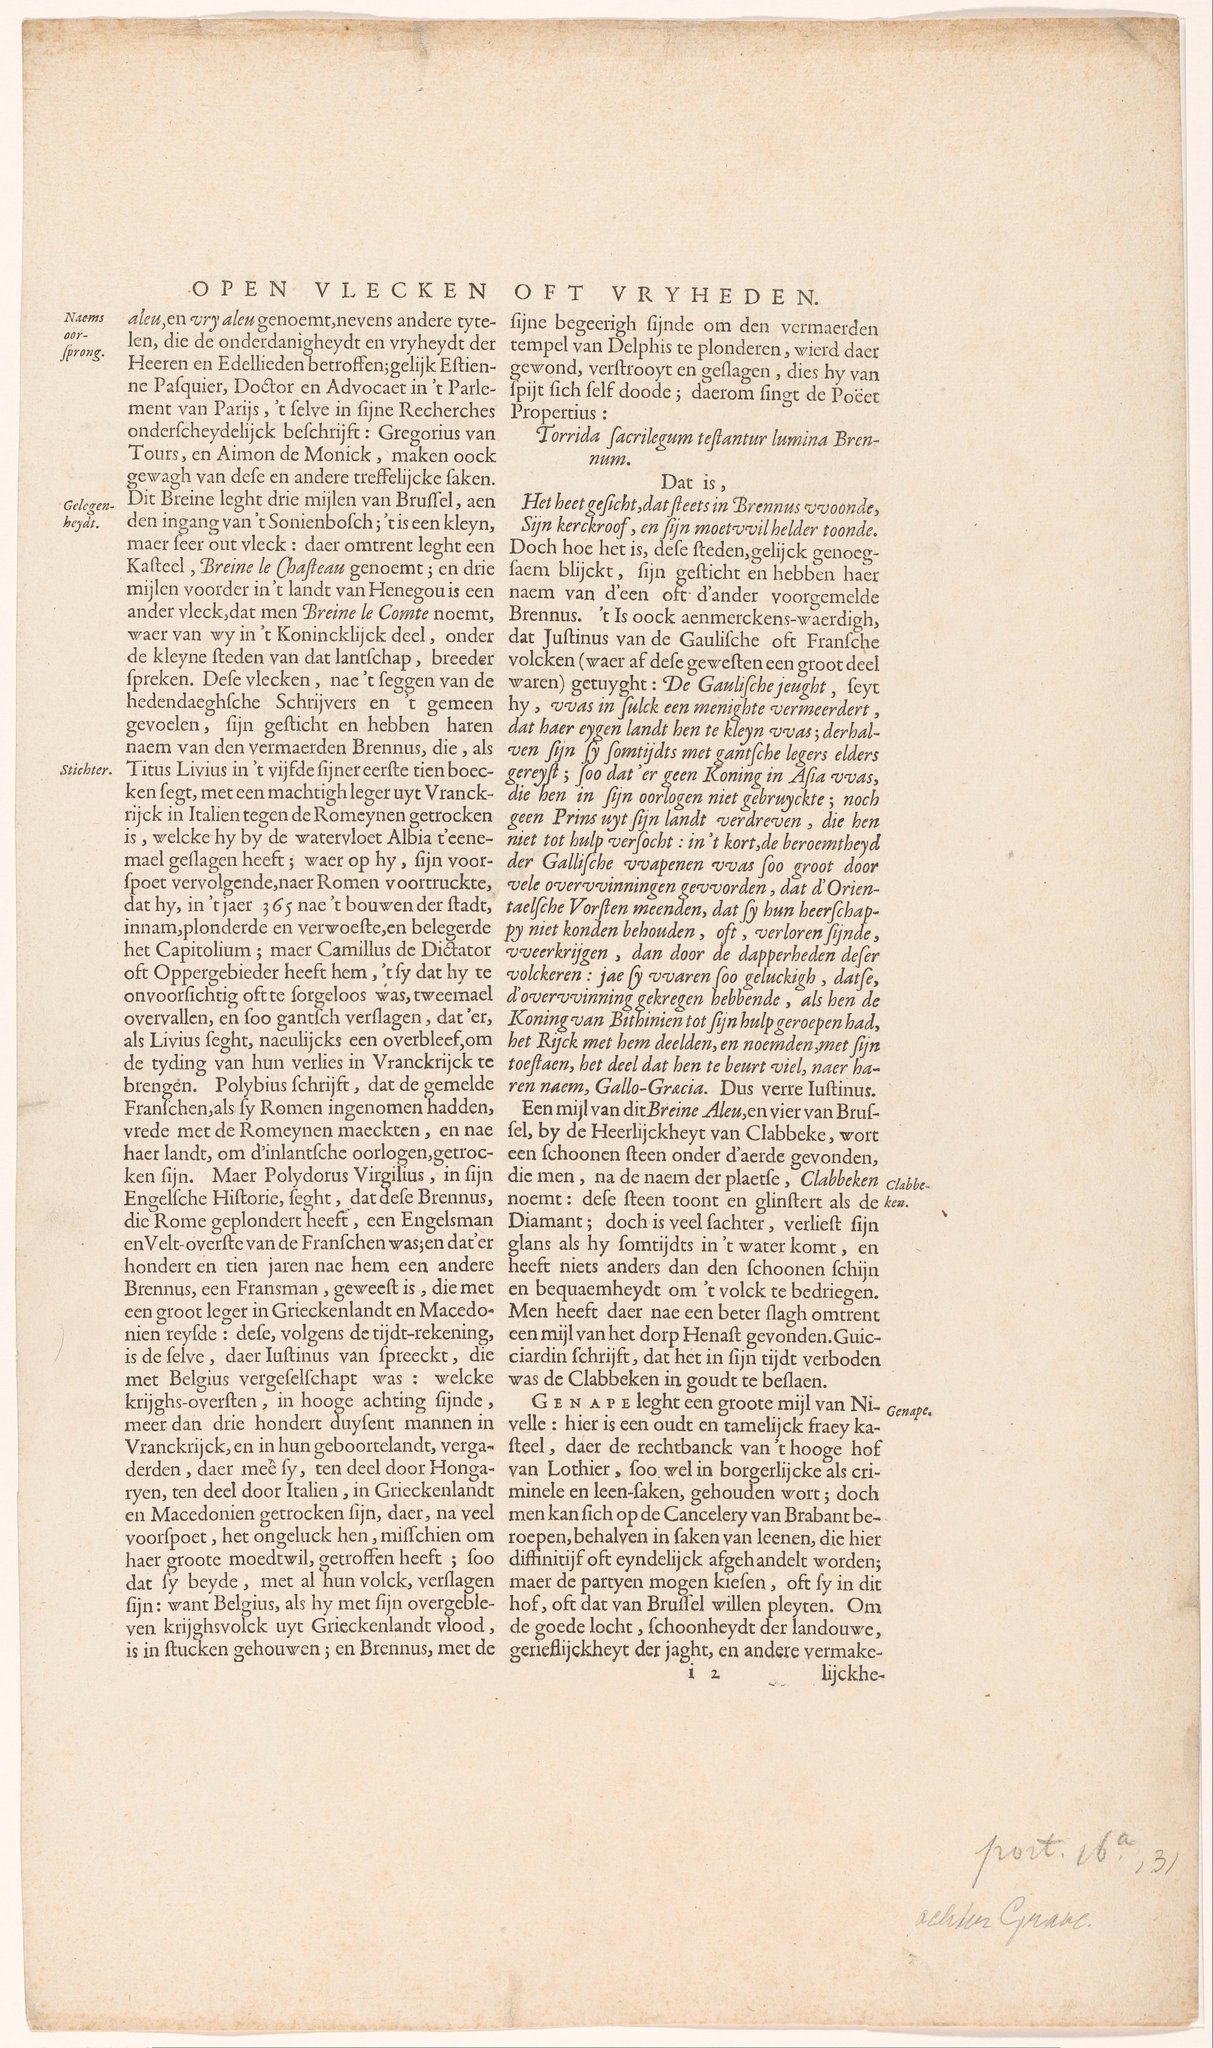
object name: text sheet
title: Deel van de beschrijving van Grave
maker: johannes willemszoon blaeu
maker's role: printer, publisher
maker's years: 1596-1673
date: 1652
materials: paper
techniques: letterpress printing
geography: amsterdam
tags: grave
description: Tekst gebruikt in: Blaeu, Johannes Willemszoon. Toonneel der steden van de Vereenighde Nederlanden. 2 delen. Amsterdam: Johannes Willemszoon Blaeu, 1652, dl. 1. Zie ook RP-P-AO-16-31-1.